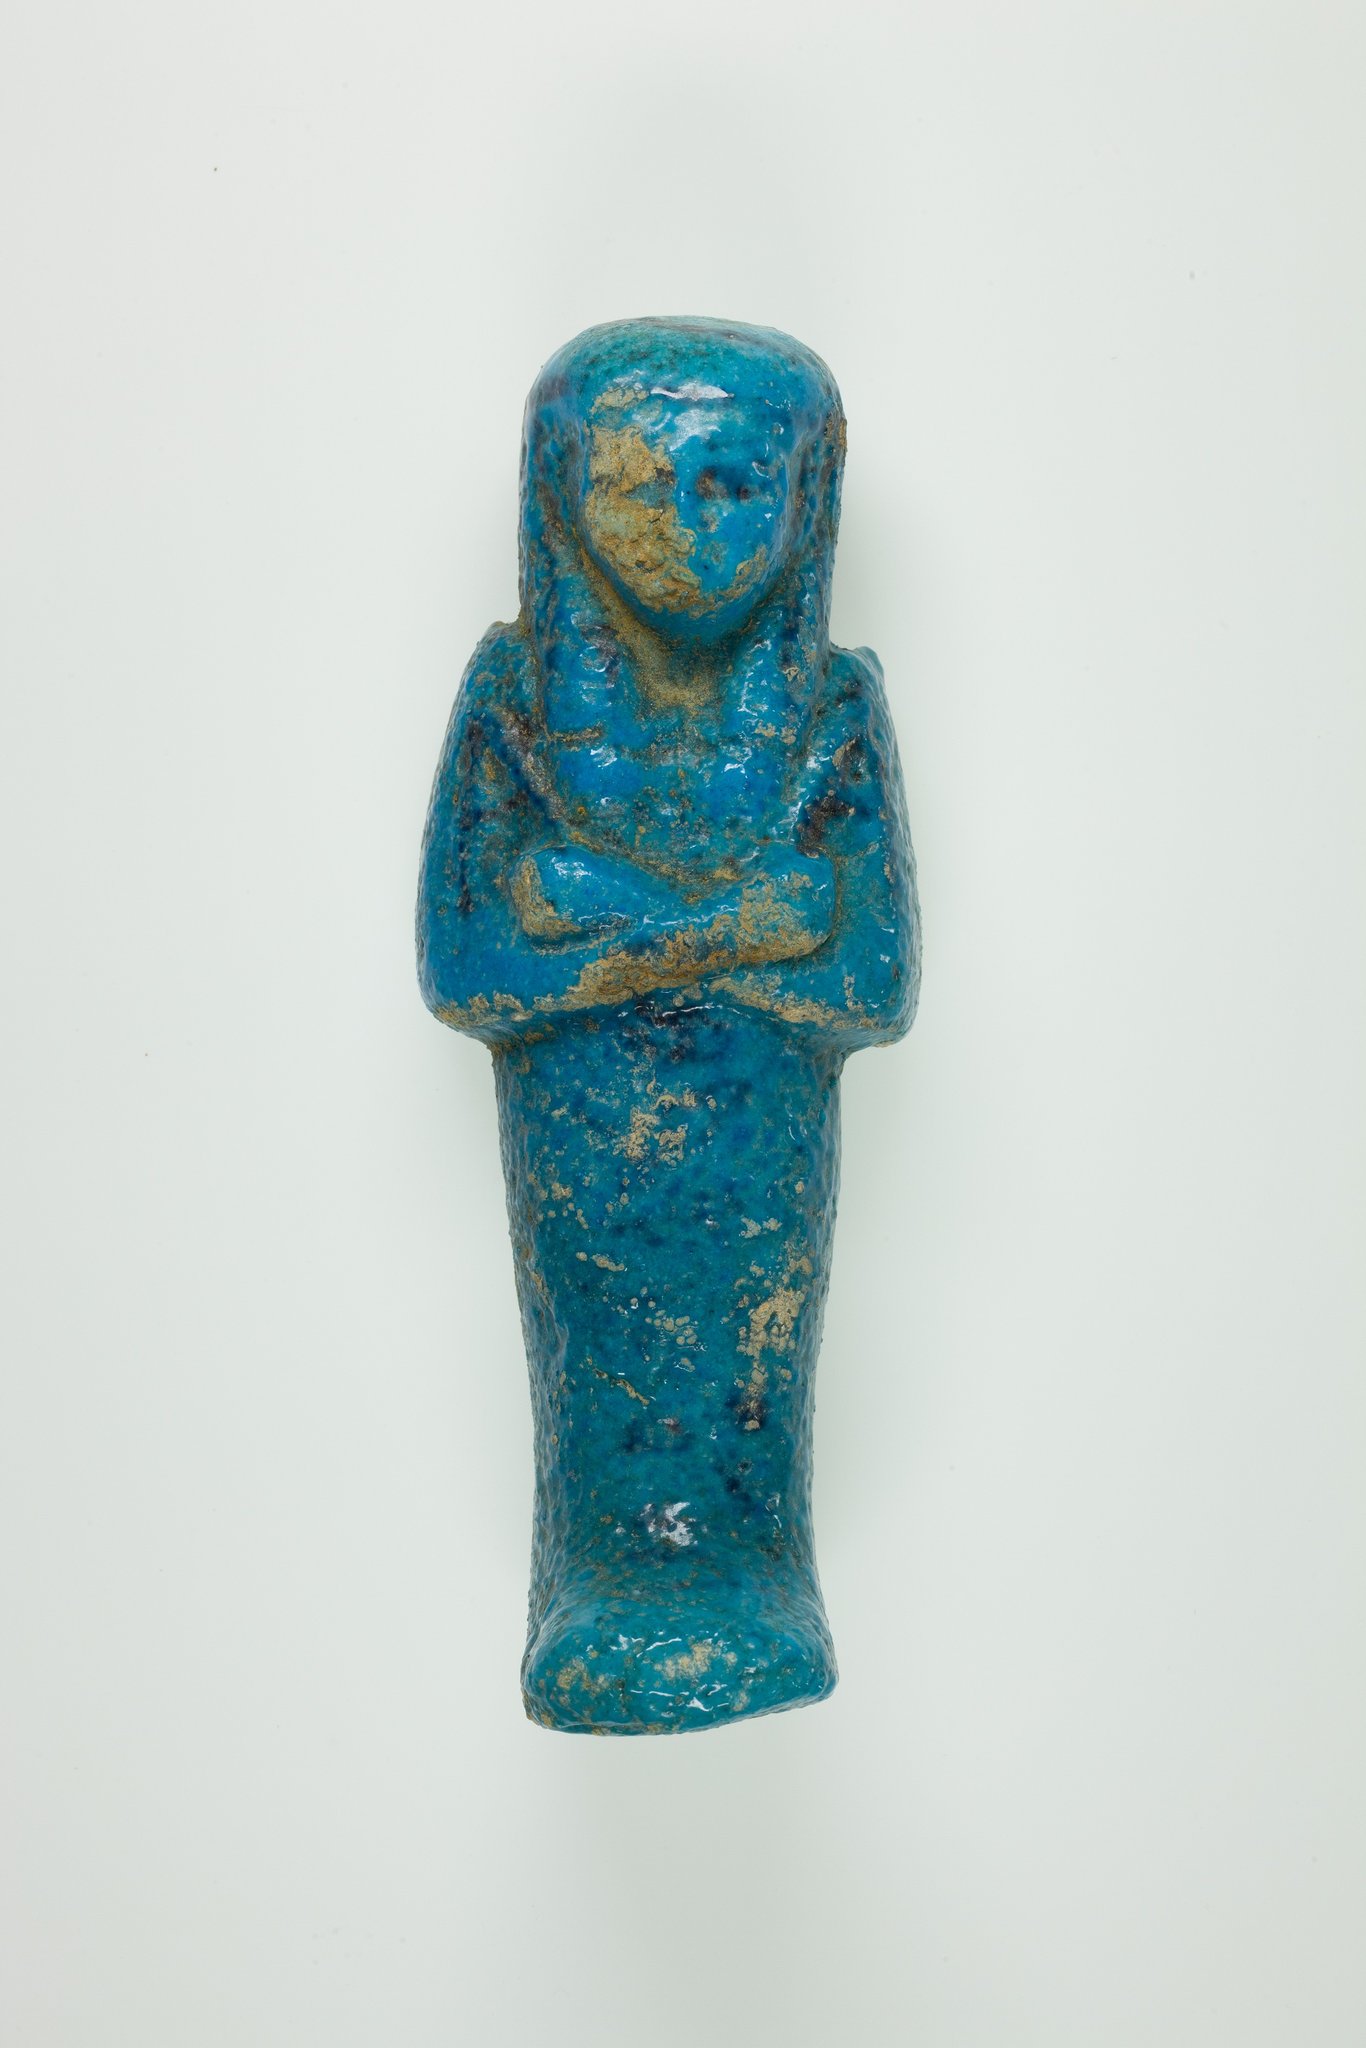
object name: worker shabti, henettawy c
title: Worker Shabti of Henettawy (C), Daughter of Isetemkheb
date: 990-970 BCE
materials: faience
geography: egypt